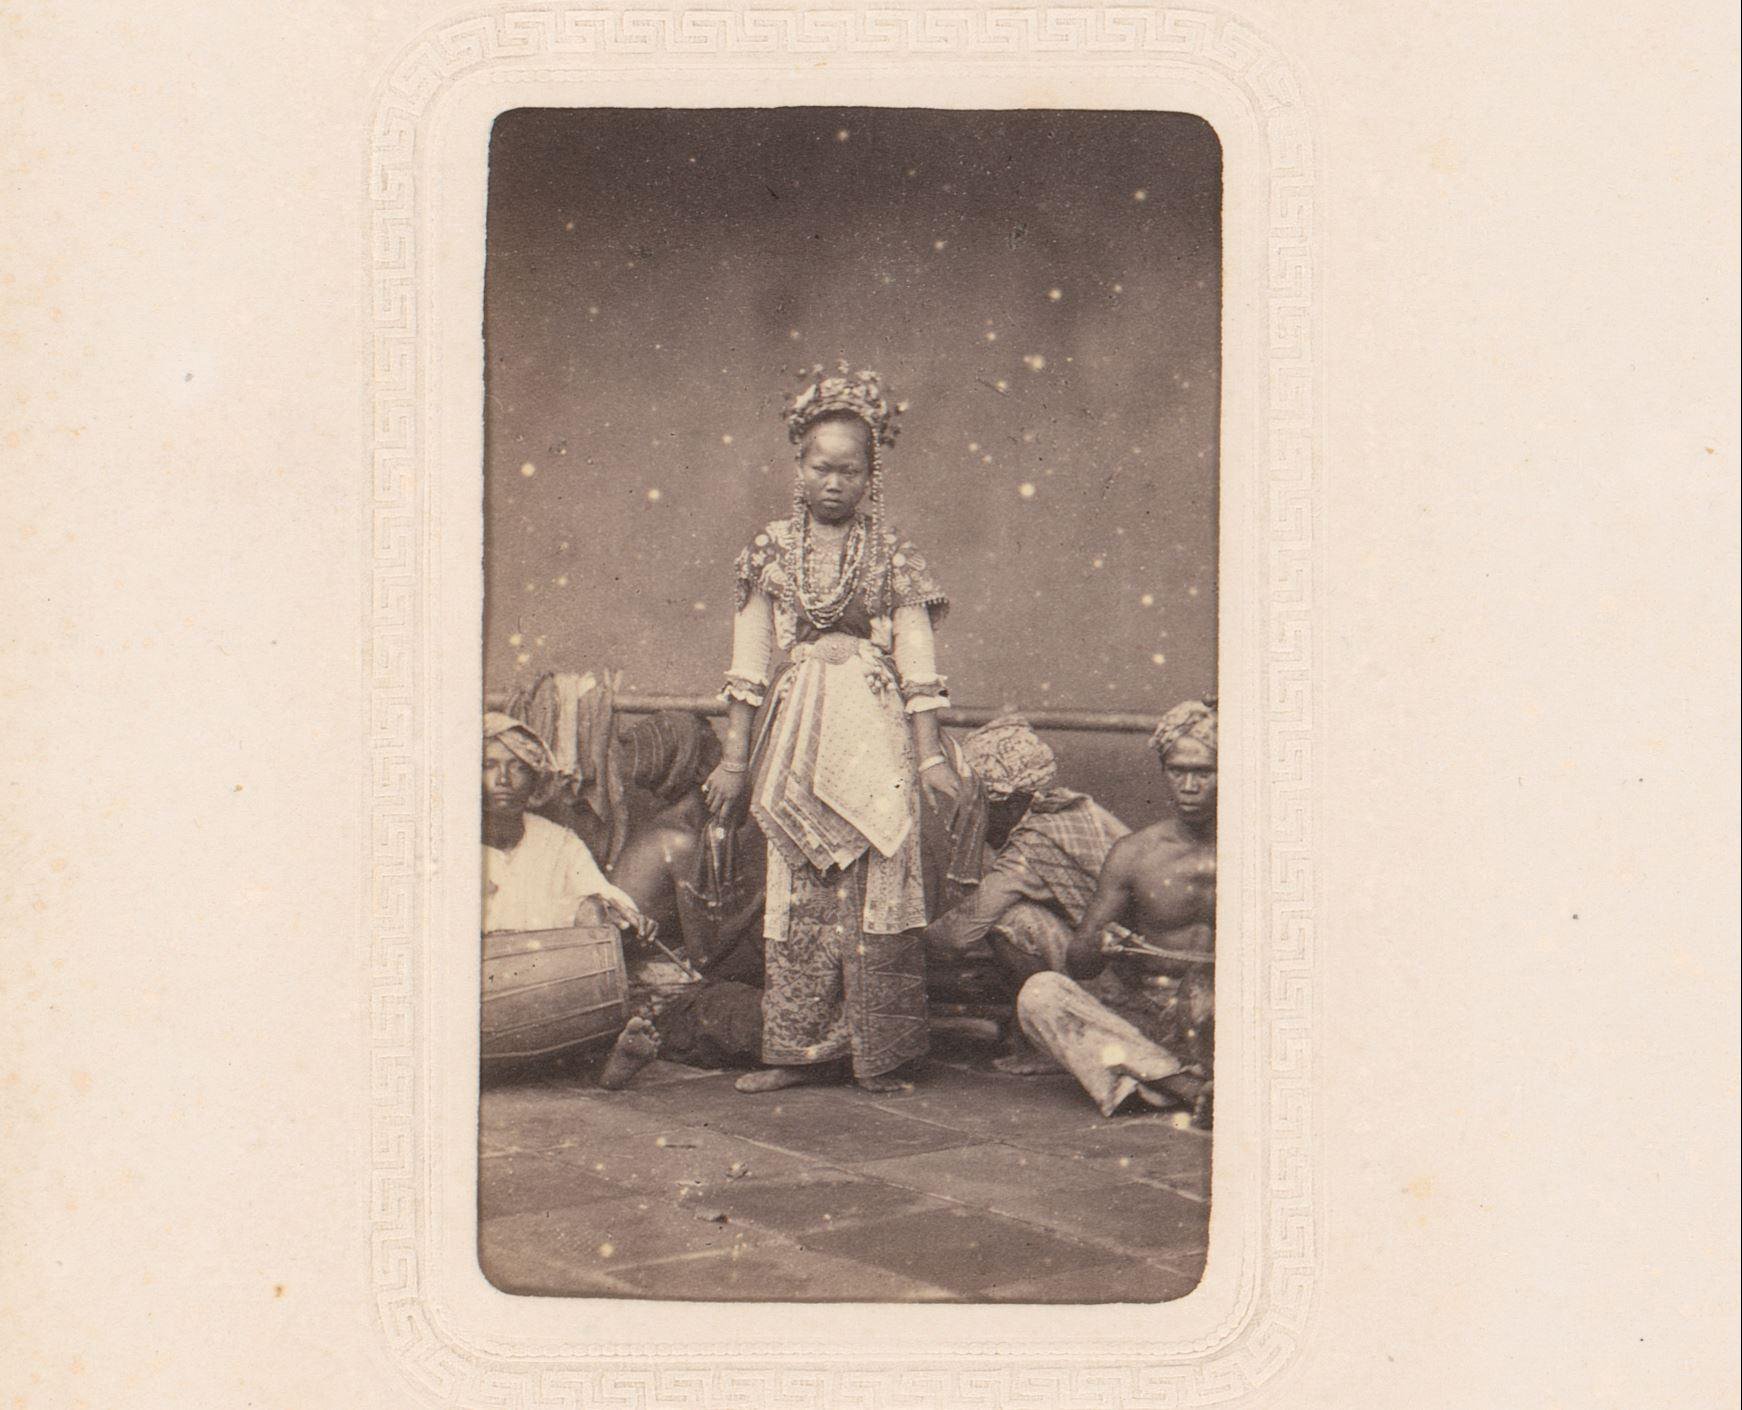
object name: album leaf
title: Portret van een danseres met muziekgroep te Indonesië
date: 1857-1880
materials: cardboard, photographic support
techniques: albumen print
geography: indonesia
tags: making music; musician with instrument, portrait of dancer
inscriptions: inscription: ‘Woodbury & Page/ Photographers/ Java’, number: ‘81’, number: ‘2’